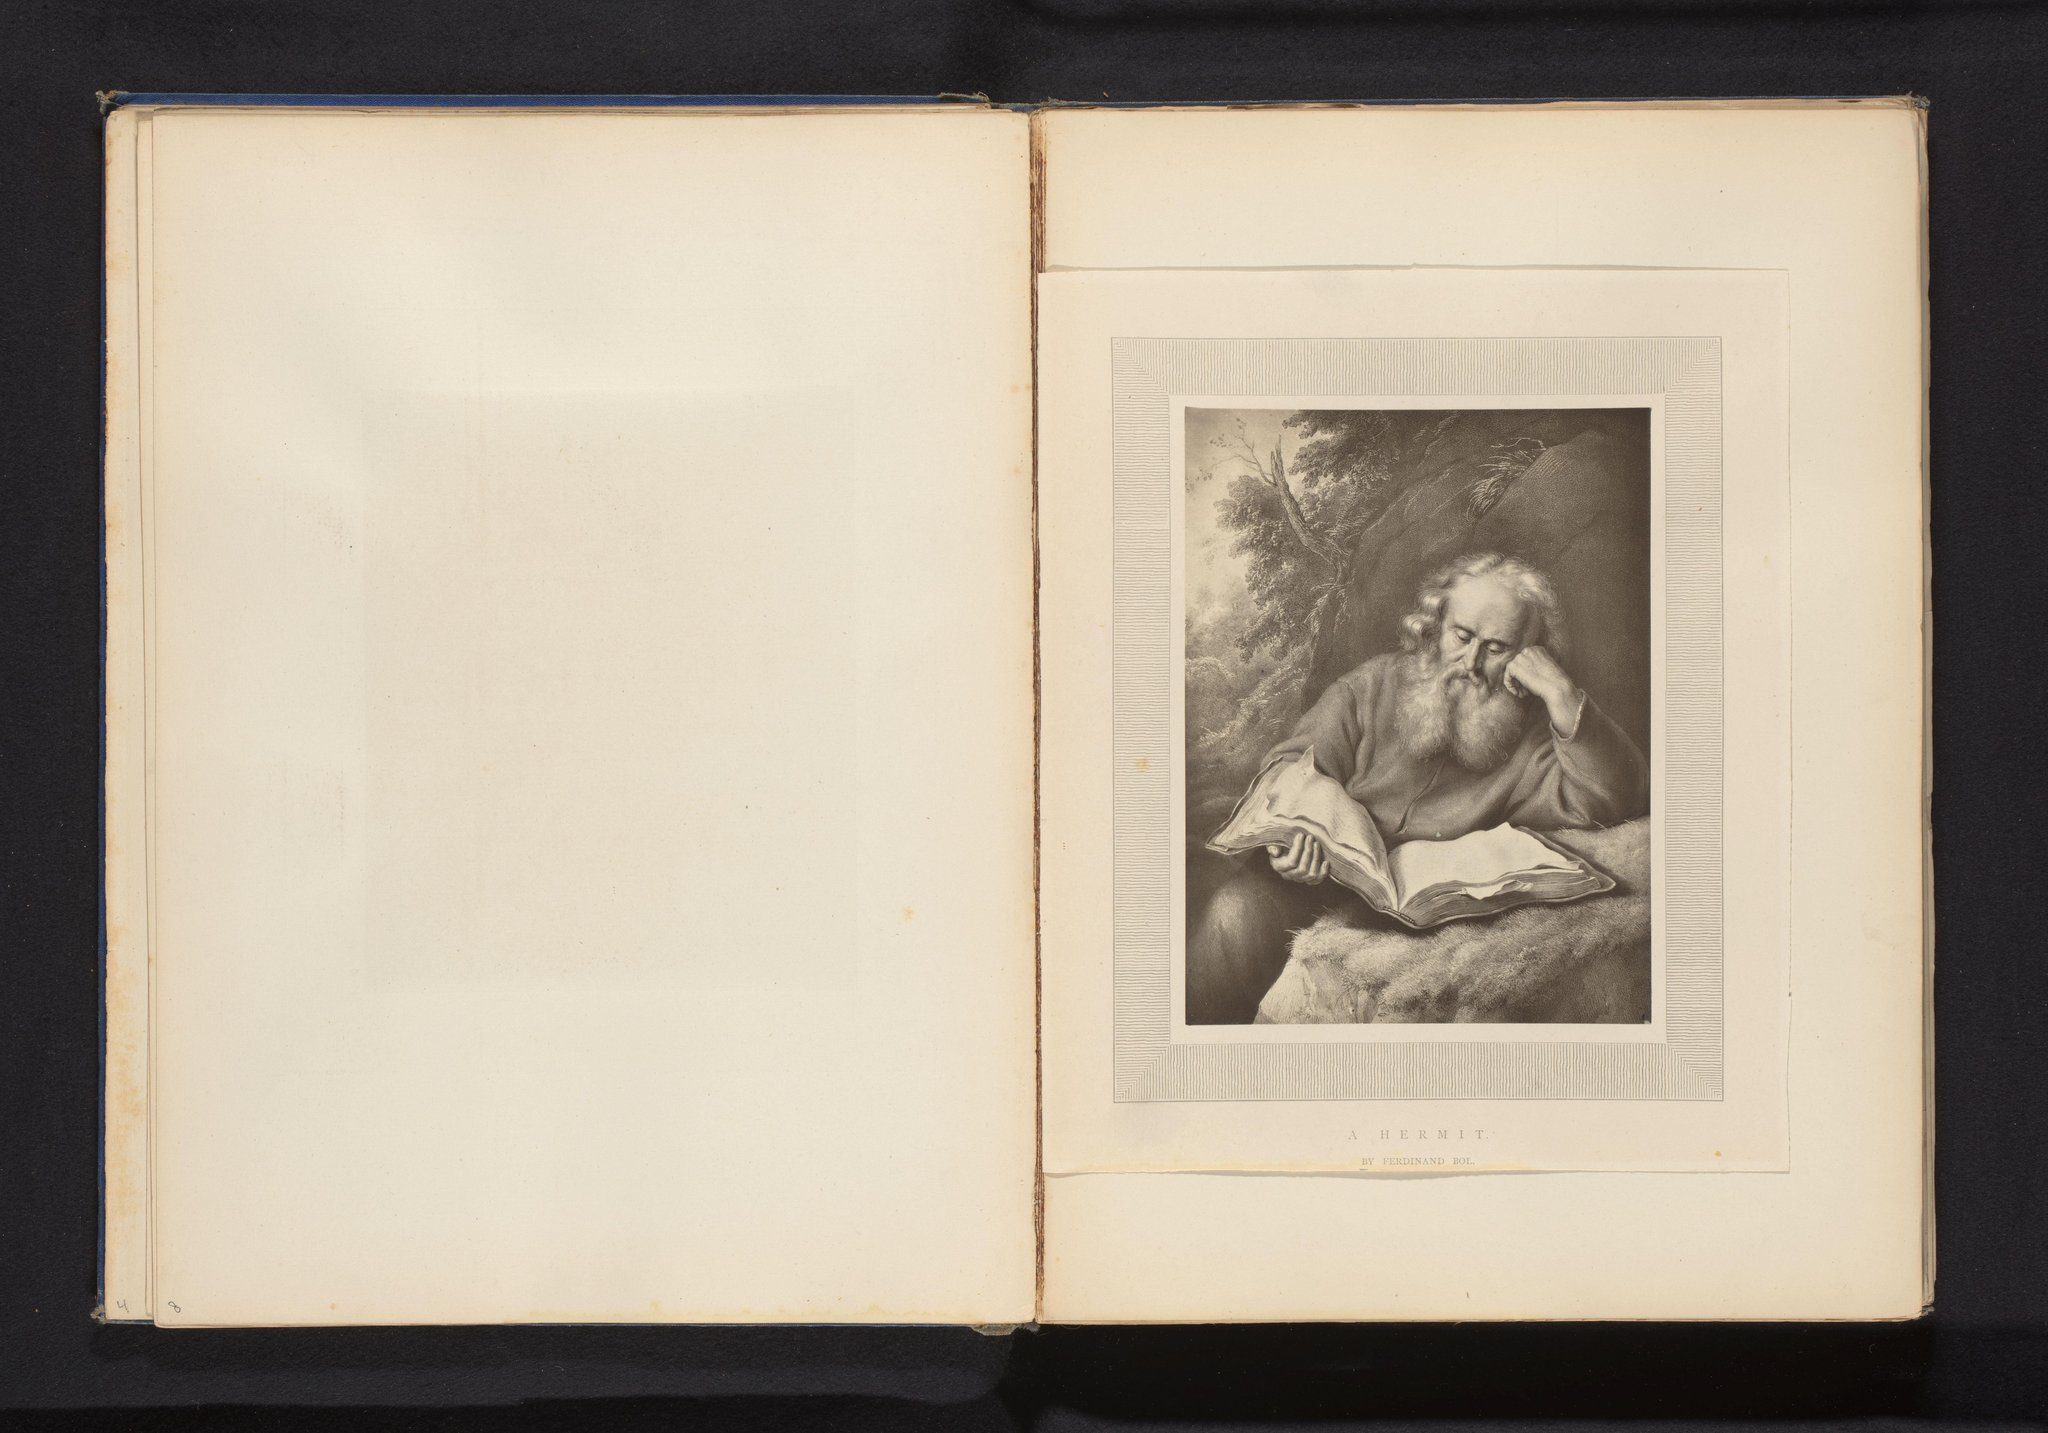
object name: reproduction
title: Reproductie van een prent van een lezende kluizenaar naar Ferdinand Bol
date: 1870-1875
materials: paper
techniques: woodburytype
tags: reading, anchorite, hermit